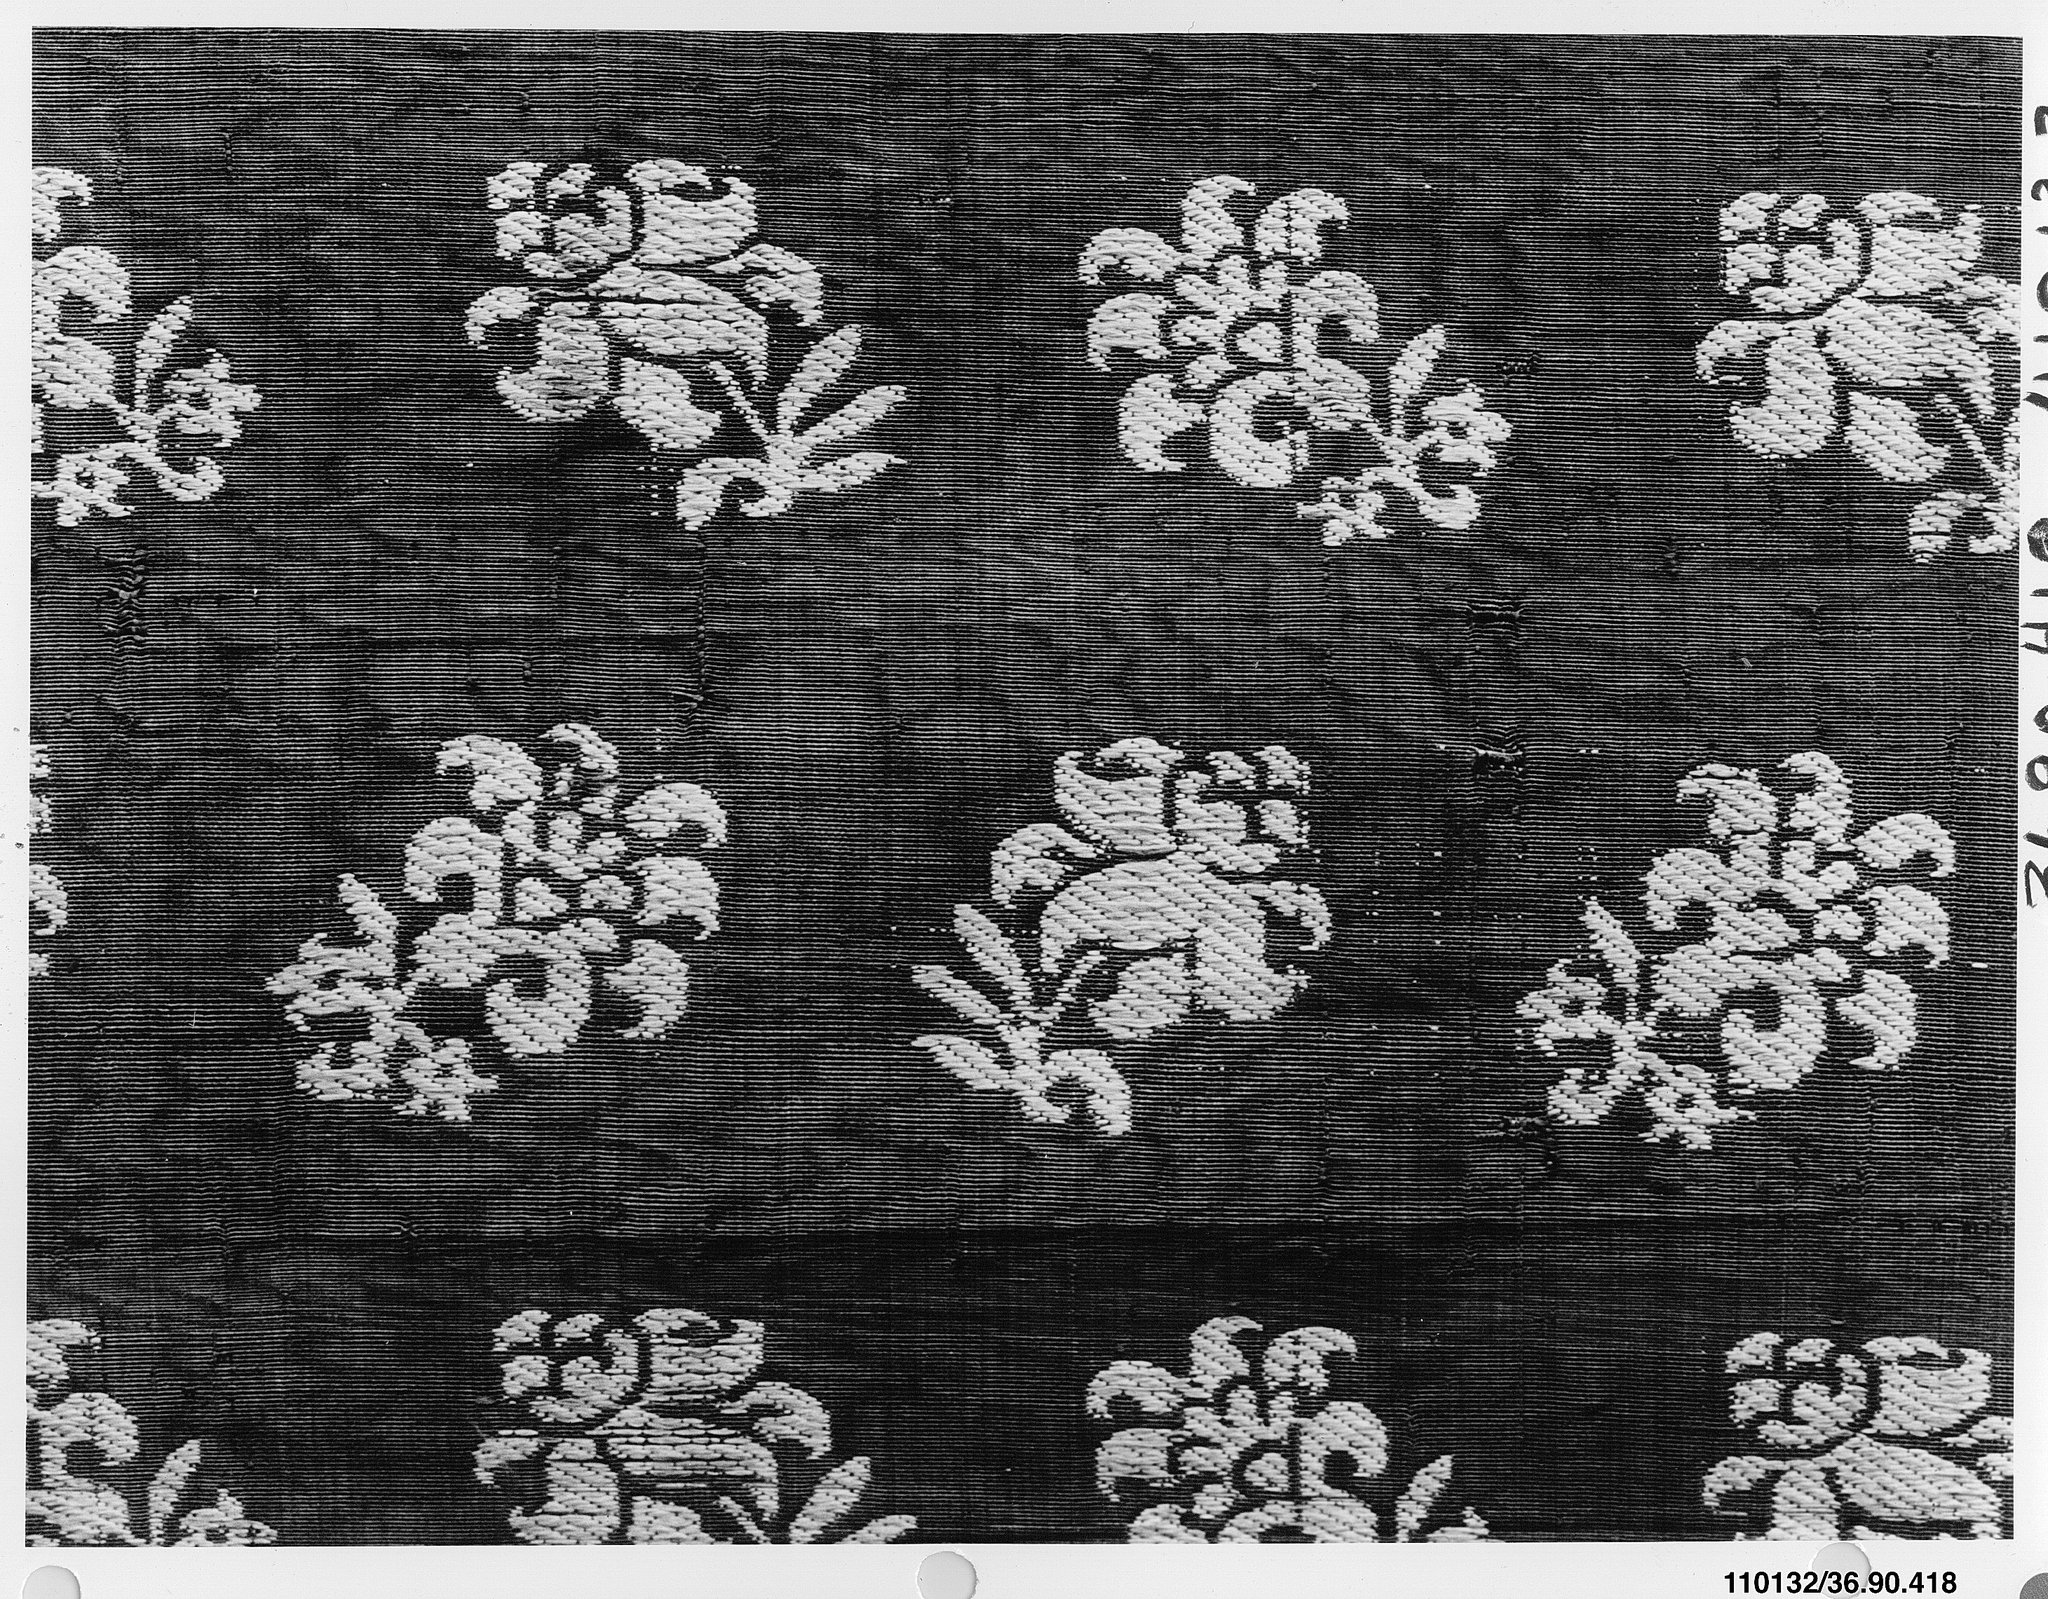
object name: piece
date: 1501-1700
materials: metal thread, silk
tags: flowers